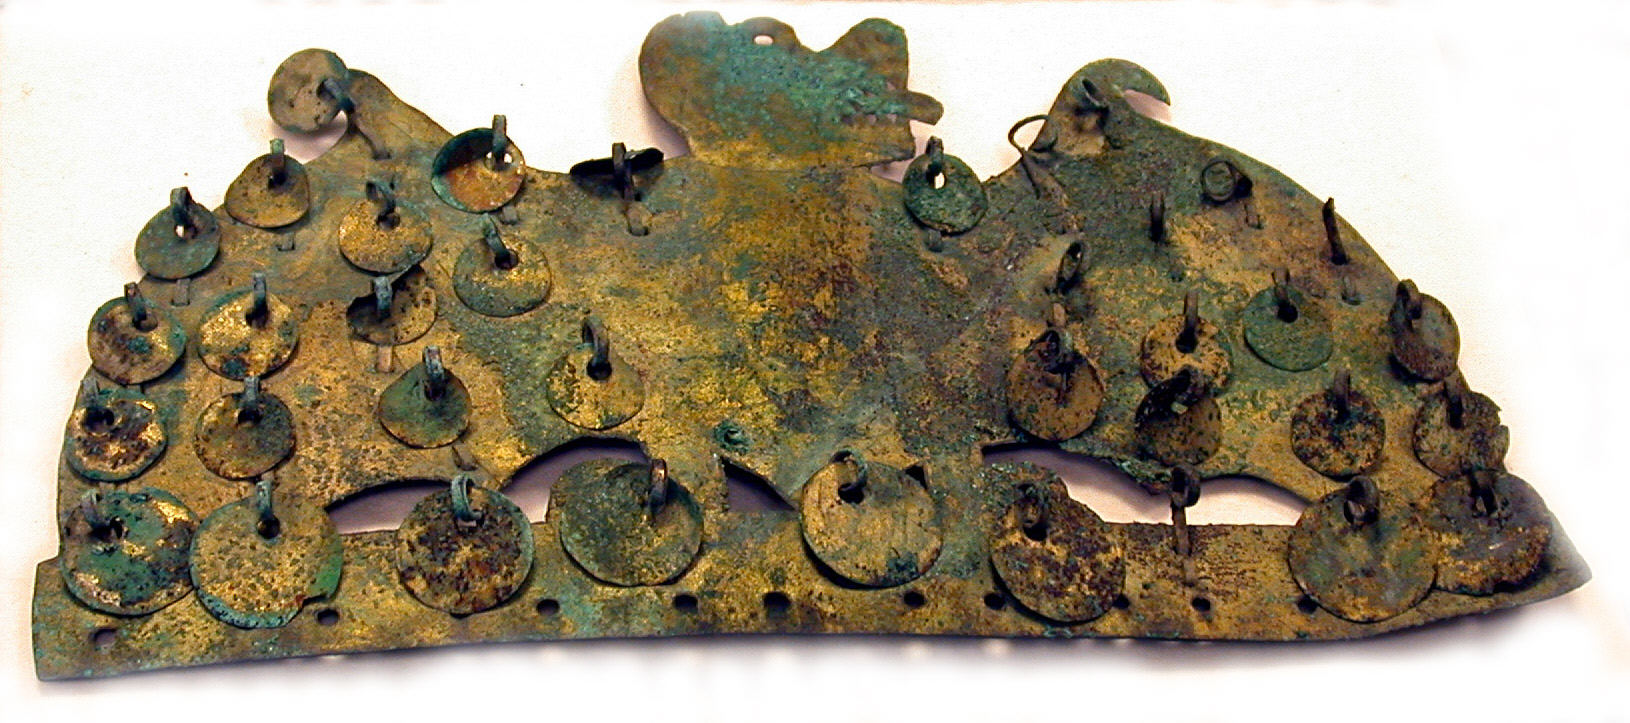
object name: ornament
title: Animal Ornament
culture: moche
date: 501-700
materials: gilt copper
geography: peru